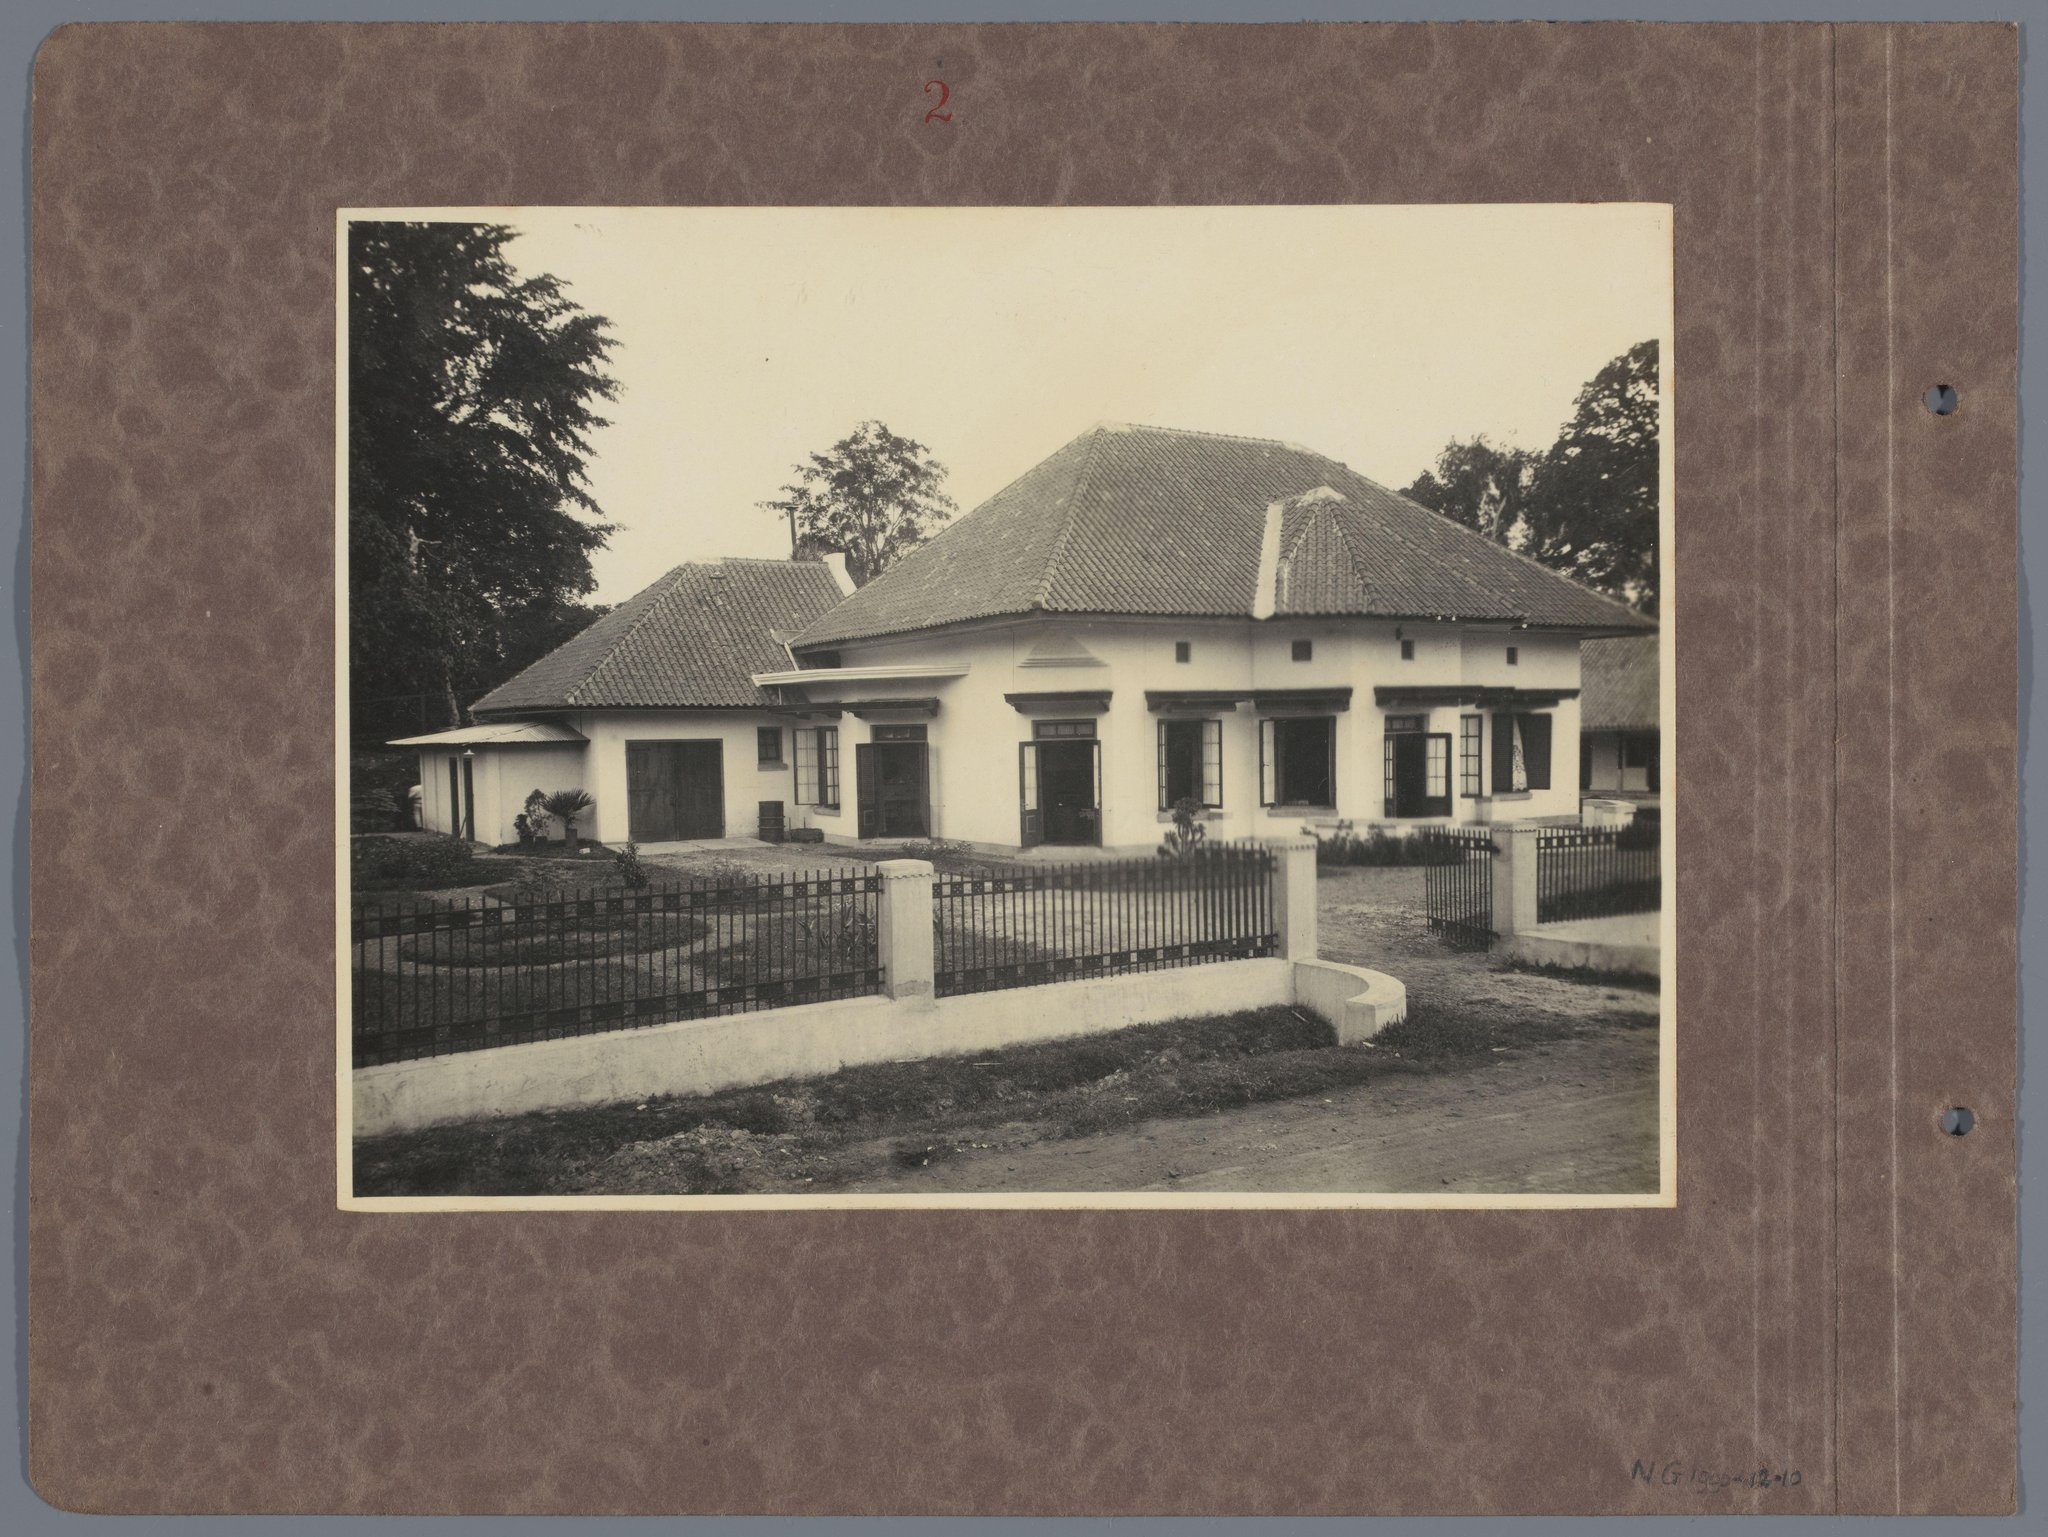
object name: photograph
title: Woonhuis met hek en tuin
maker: Anonymous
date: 1900-1940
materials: cardboard, photographic support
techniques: gelatin silver print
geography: sumatra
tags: sumatra, dutch east indies, the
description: Gezicht op een woonhuis met hek en tuin. Foto opgeplakt op een albumblad genomen uit een fotoalbum. Onderdeel van een groep van 14 losse foto's genomen op Midden- en Zuid-Sumatra in de periode ca. 1900-1940.